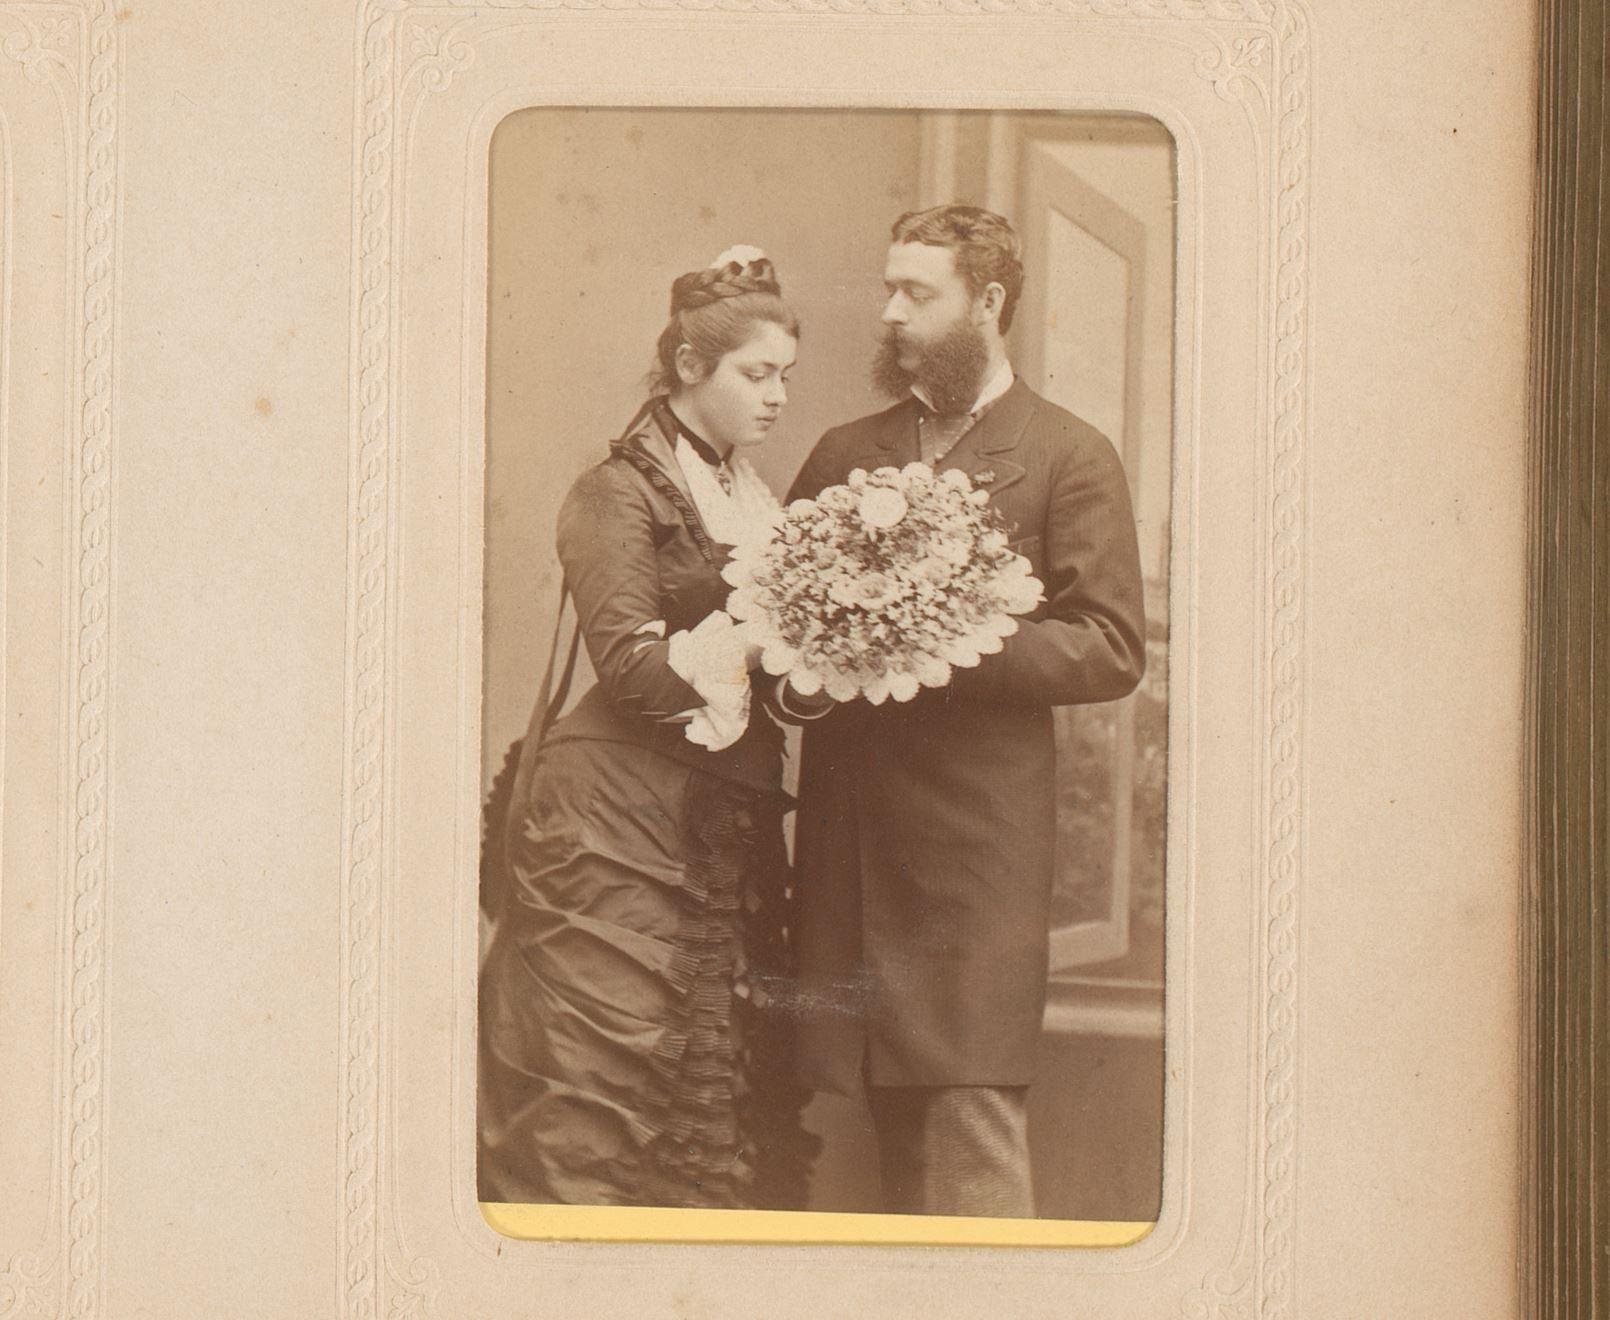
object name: carte de visite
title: Portret van een staande man en vrouw met een boeket bloemen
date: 1873-1900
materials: cardboard, photographic support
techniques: albumen print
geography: prague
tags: standing figure, cut flowers; nosegay, bunch of flowers, historical persons - bb - woman, historical persons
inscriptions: inscription: ‘(...) PRAHA/ H. ECKERT/ (...)/ J. MÜLLERN/ PRAG/ Osoby anímají se jen od 10 hod. dop. az do 2 hod. odpol./ Vozy mohou az k prjiimacimu salonu dojeti./ Personen-Aufnahmen finden nur von 10 Uhr Vorm. bis 2 Uhr/ (...)’